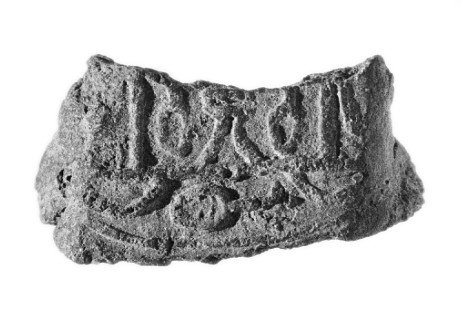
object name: sealing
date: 1981-1640 BCE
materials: clay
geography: egypt